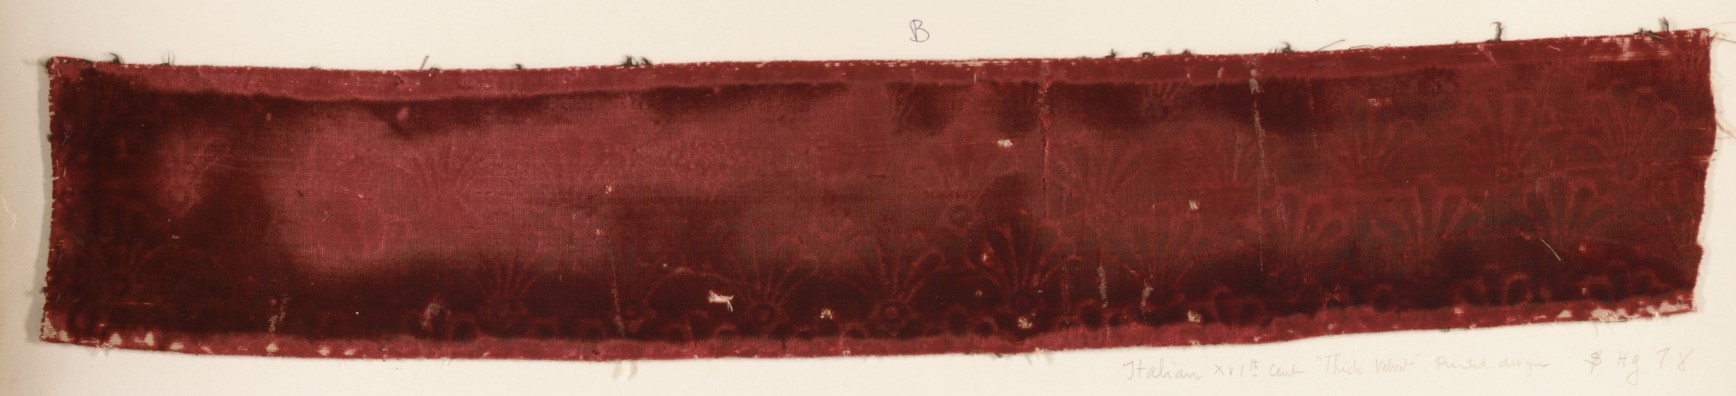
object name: fragment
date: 1501-1600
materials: silk